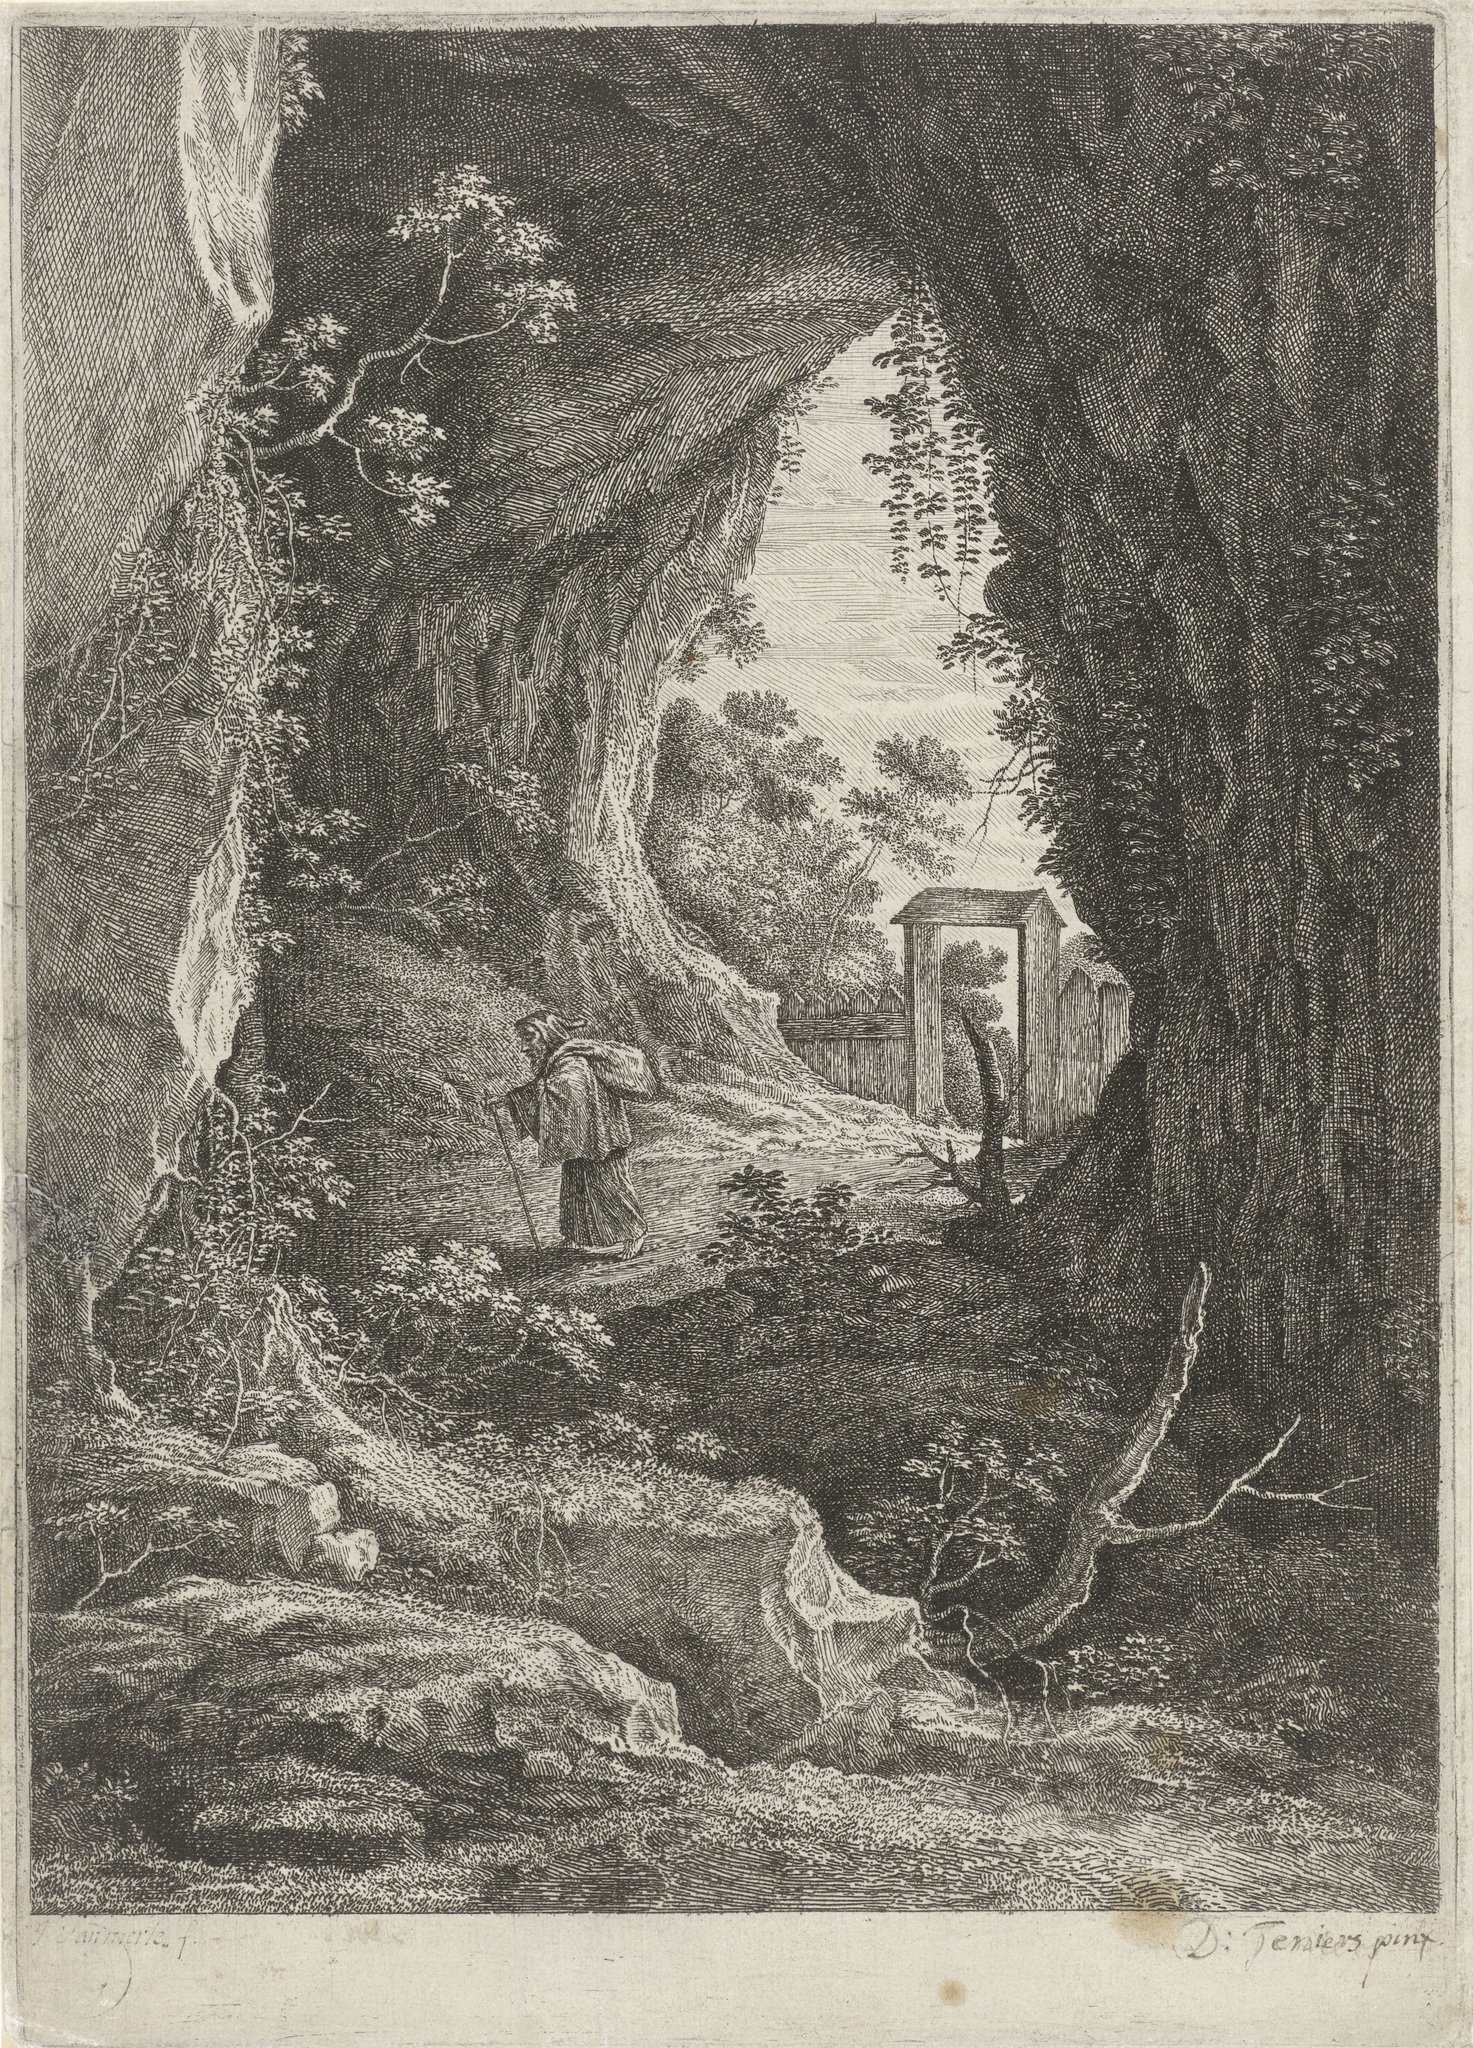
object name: print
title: Kluizenaar tussen overhangende rotsen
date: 1619-1672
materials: paper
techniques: engraving, etching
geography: antwerp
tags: anchorite, hermit, rock-formations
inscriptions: collector's mark: Lugt 514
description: Een kluizenaar loopt met een wandelstok en een zak op zijn rug tussen overhangende rotsen. Op de achtergrond een poort.